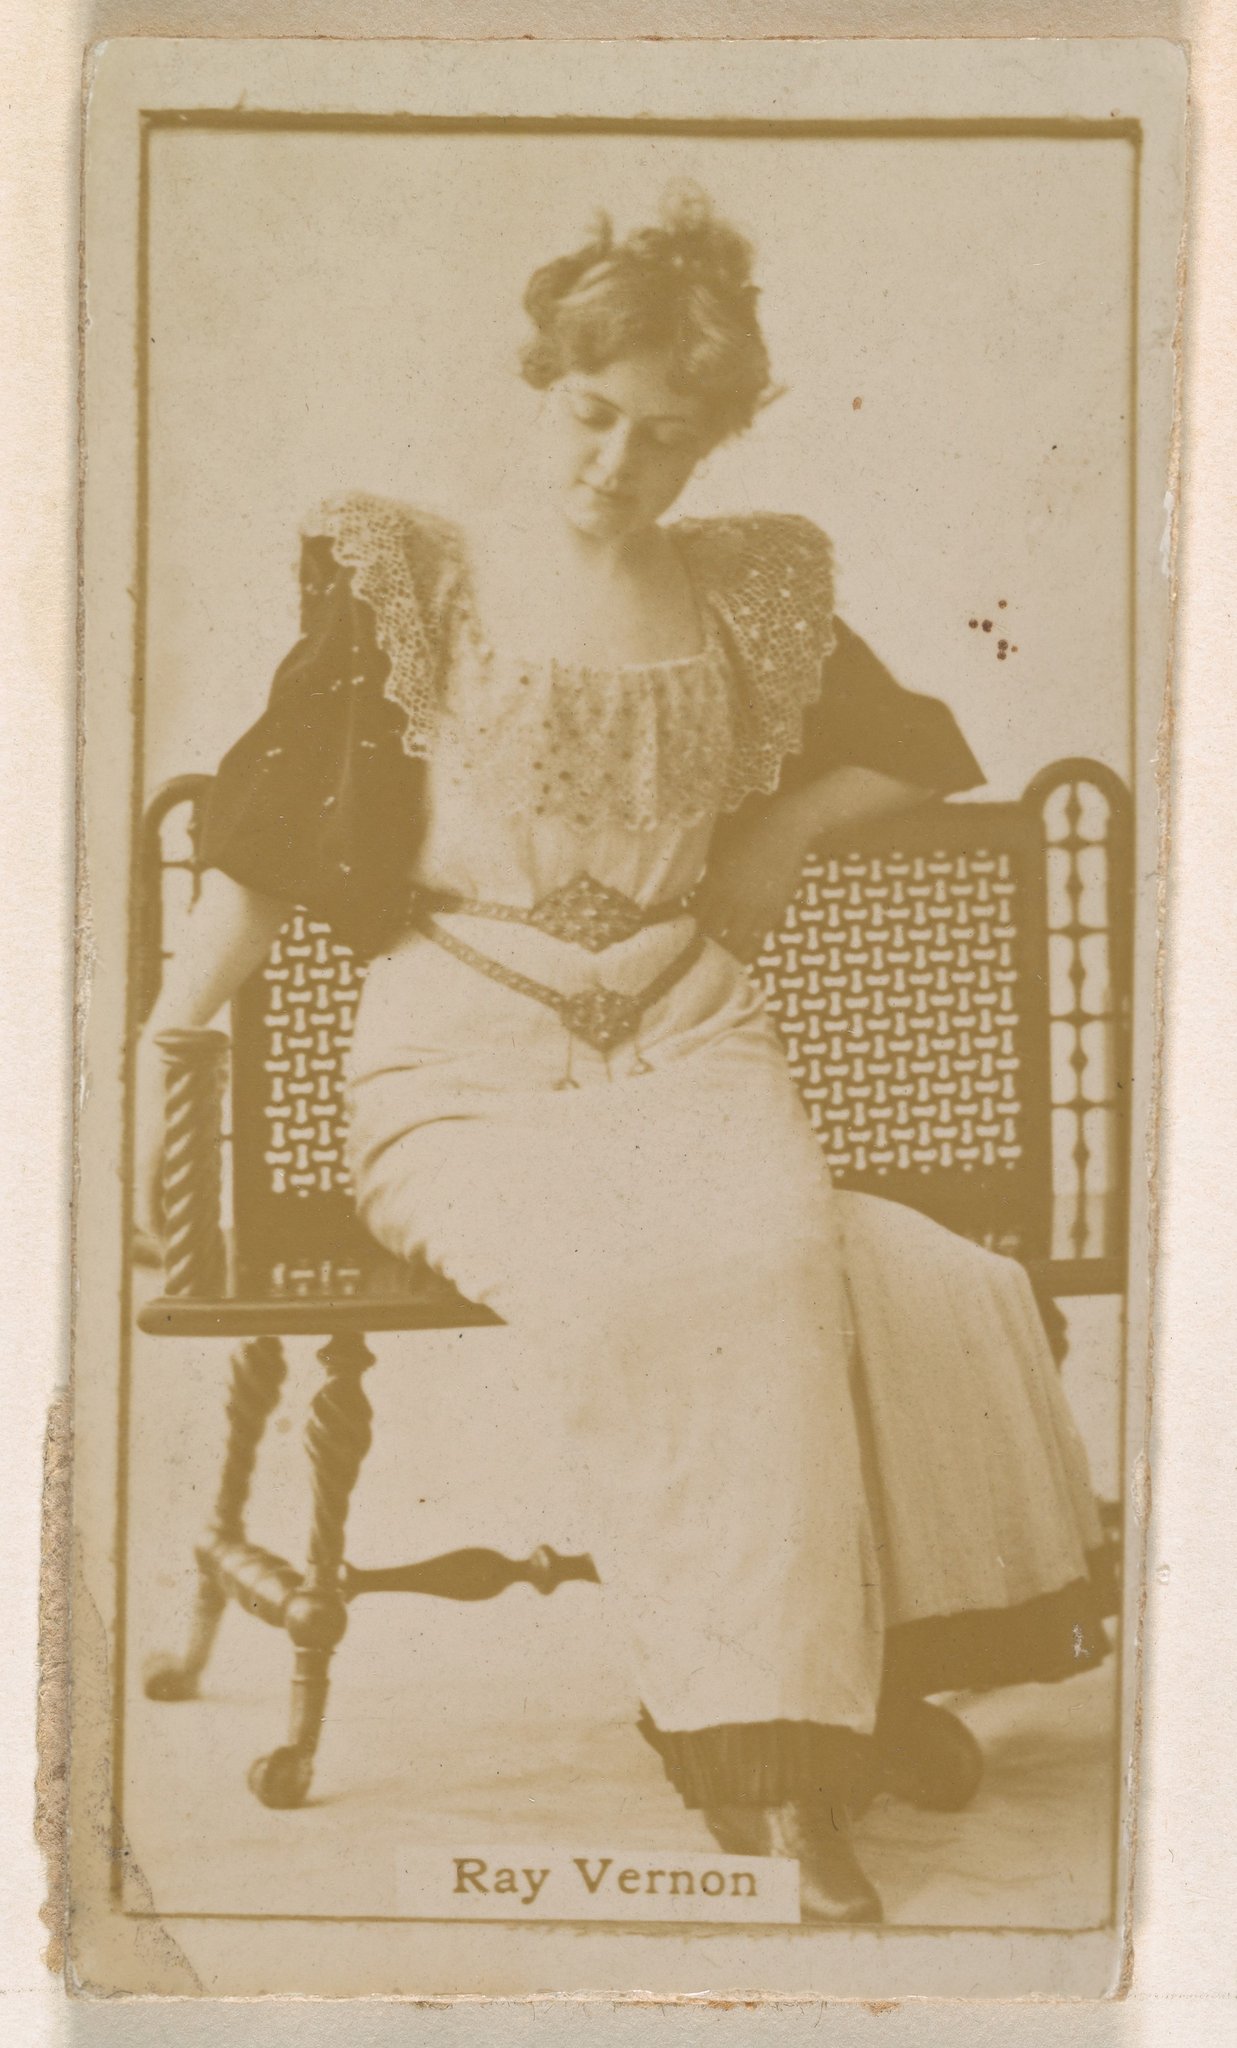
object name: photograph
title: Ray Vernon, from the Actresses series (N245) issued by Kinney Brothers to promote Sweet Caporal Cigarettes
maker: kinney brothers tobacco company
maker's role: publisher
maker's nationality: american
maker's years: 1869-2011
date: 1890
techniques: albumen silver print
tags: portraits,women,actresses